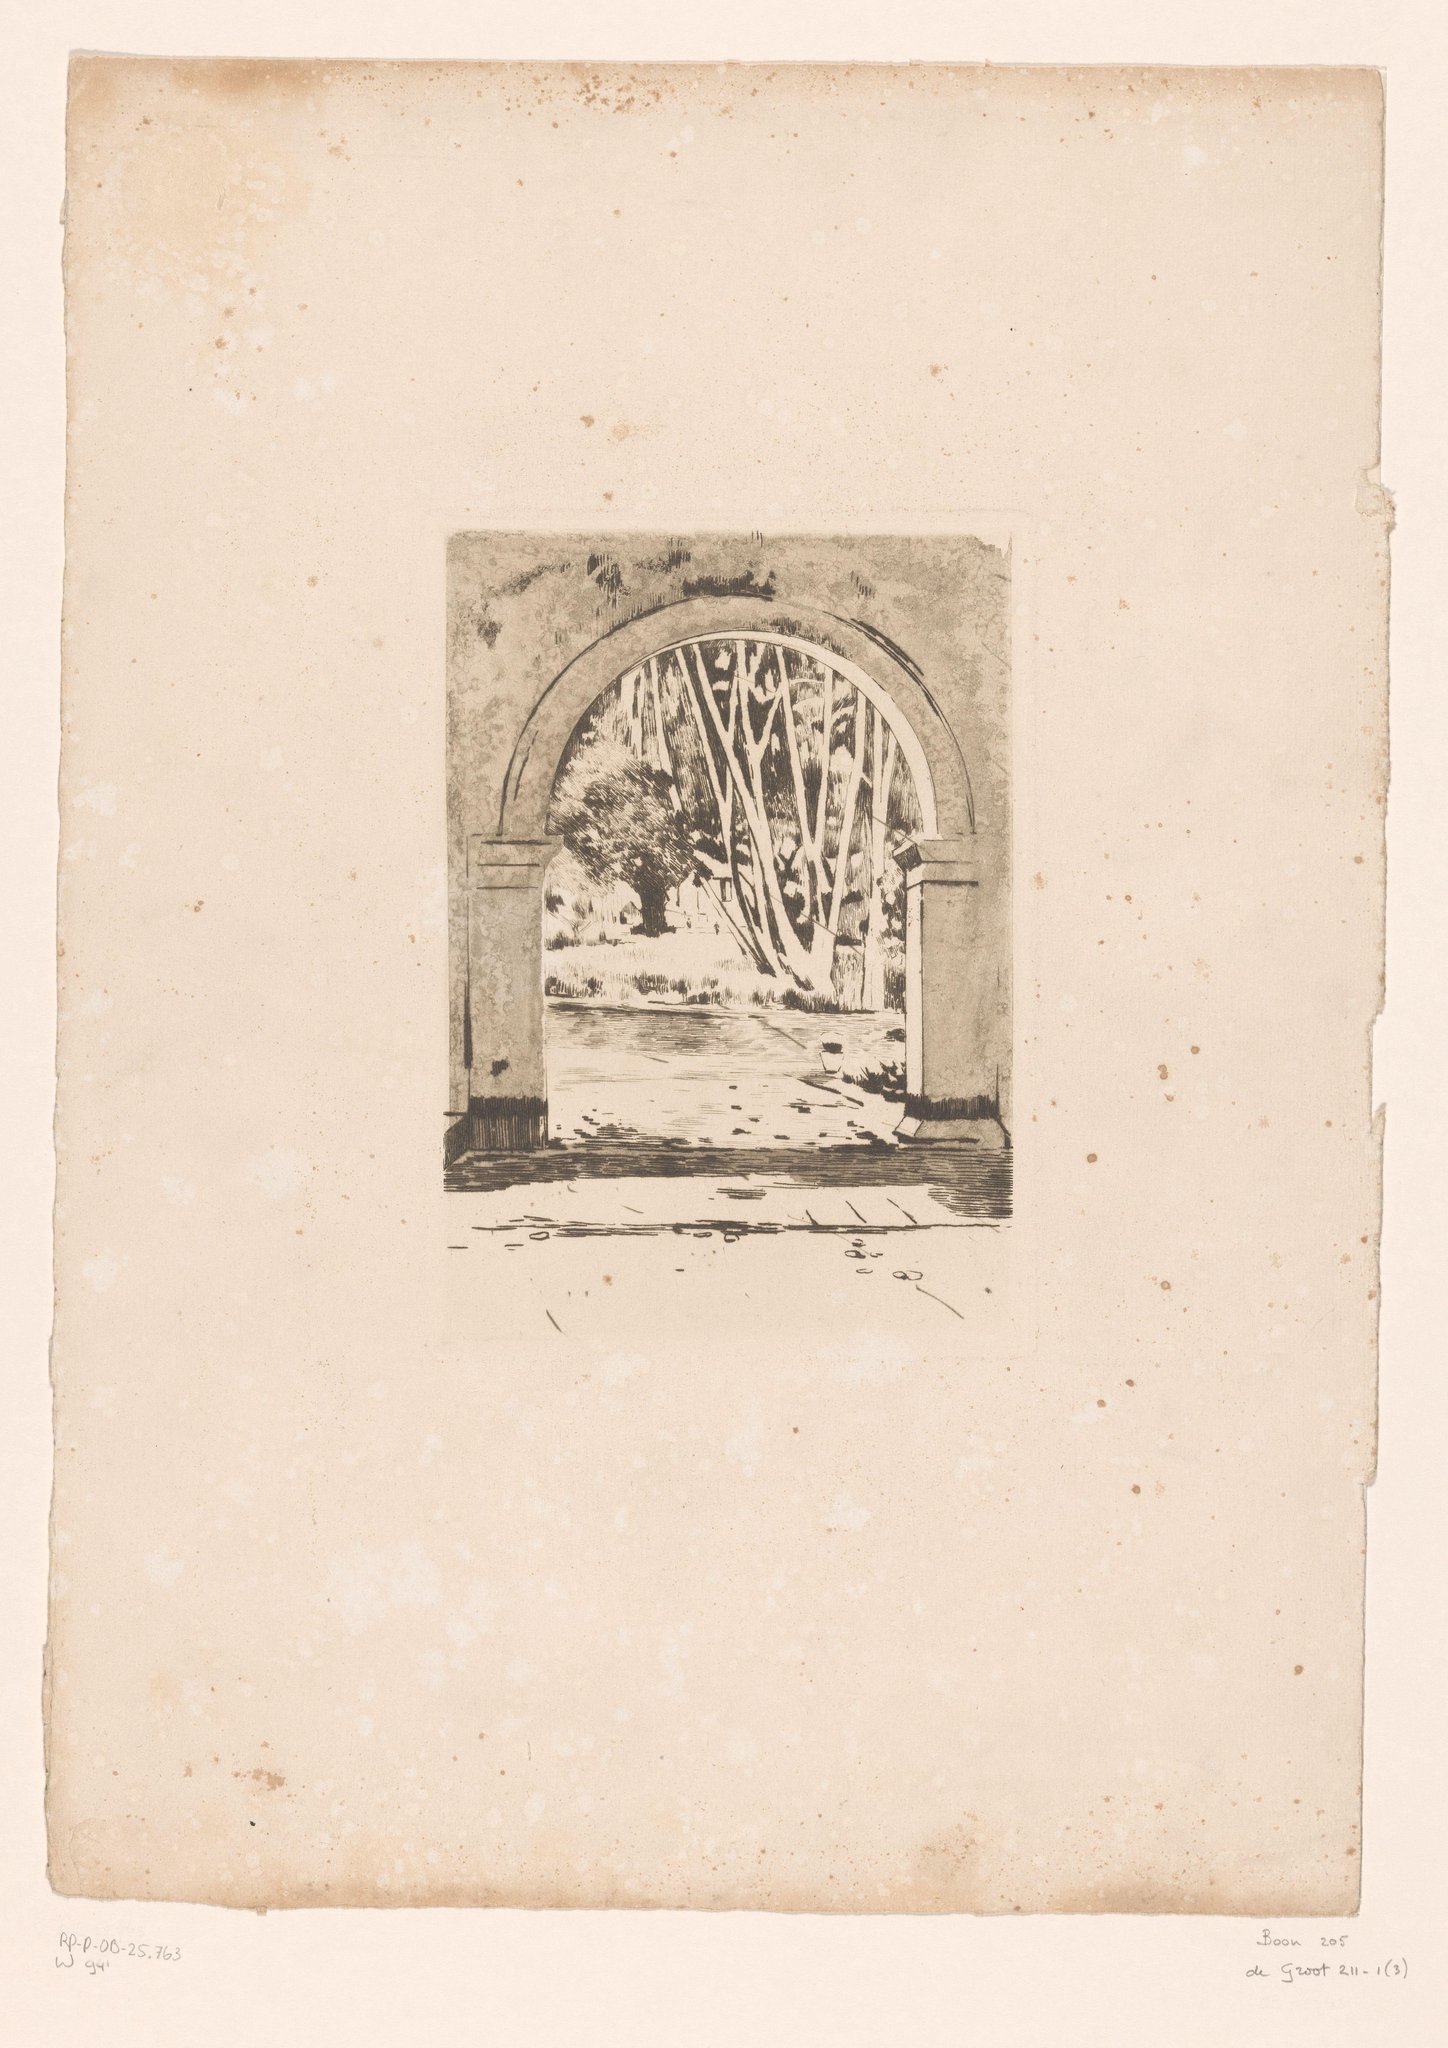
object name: print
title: Poort van Hotel Bellevue in Buitenzorg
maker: willem witsen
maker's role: draughtsman, painter, print maker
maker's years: 1860-1923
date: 1921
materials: paper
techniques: aquatint, etching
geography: amsterdam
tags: plantation, arch, archivolt ~ architecture